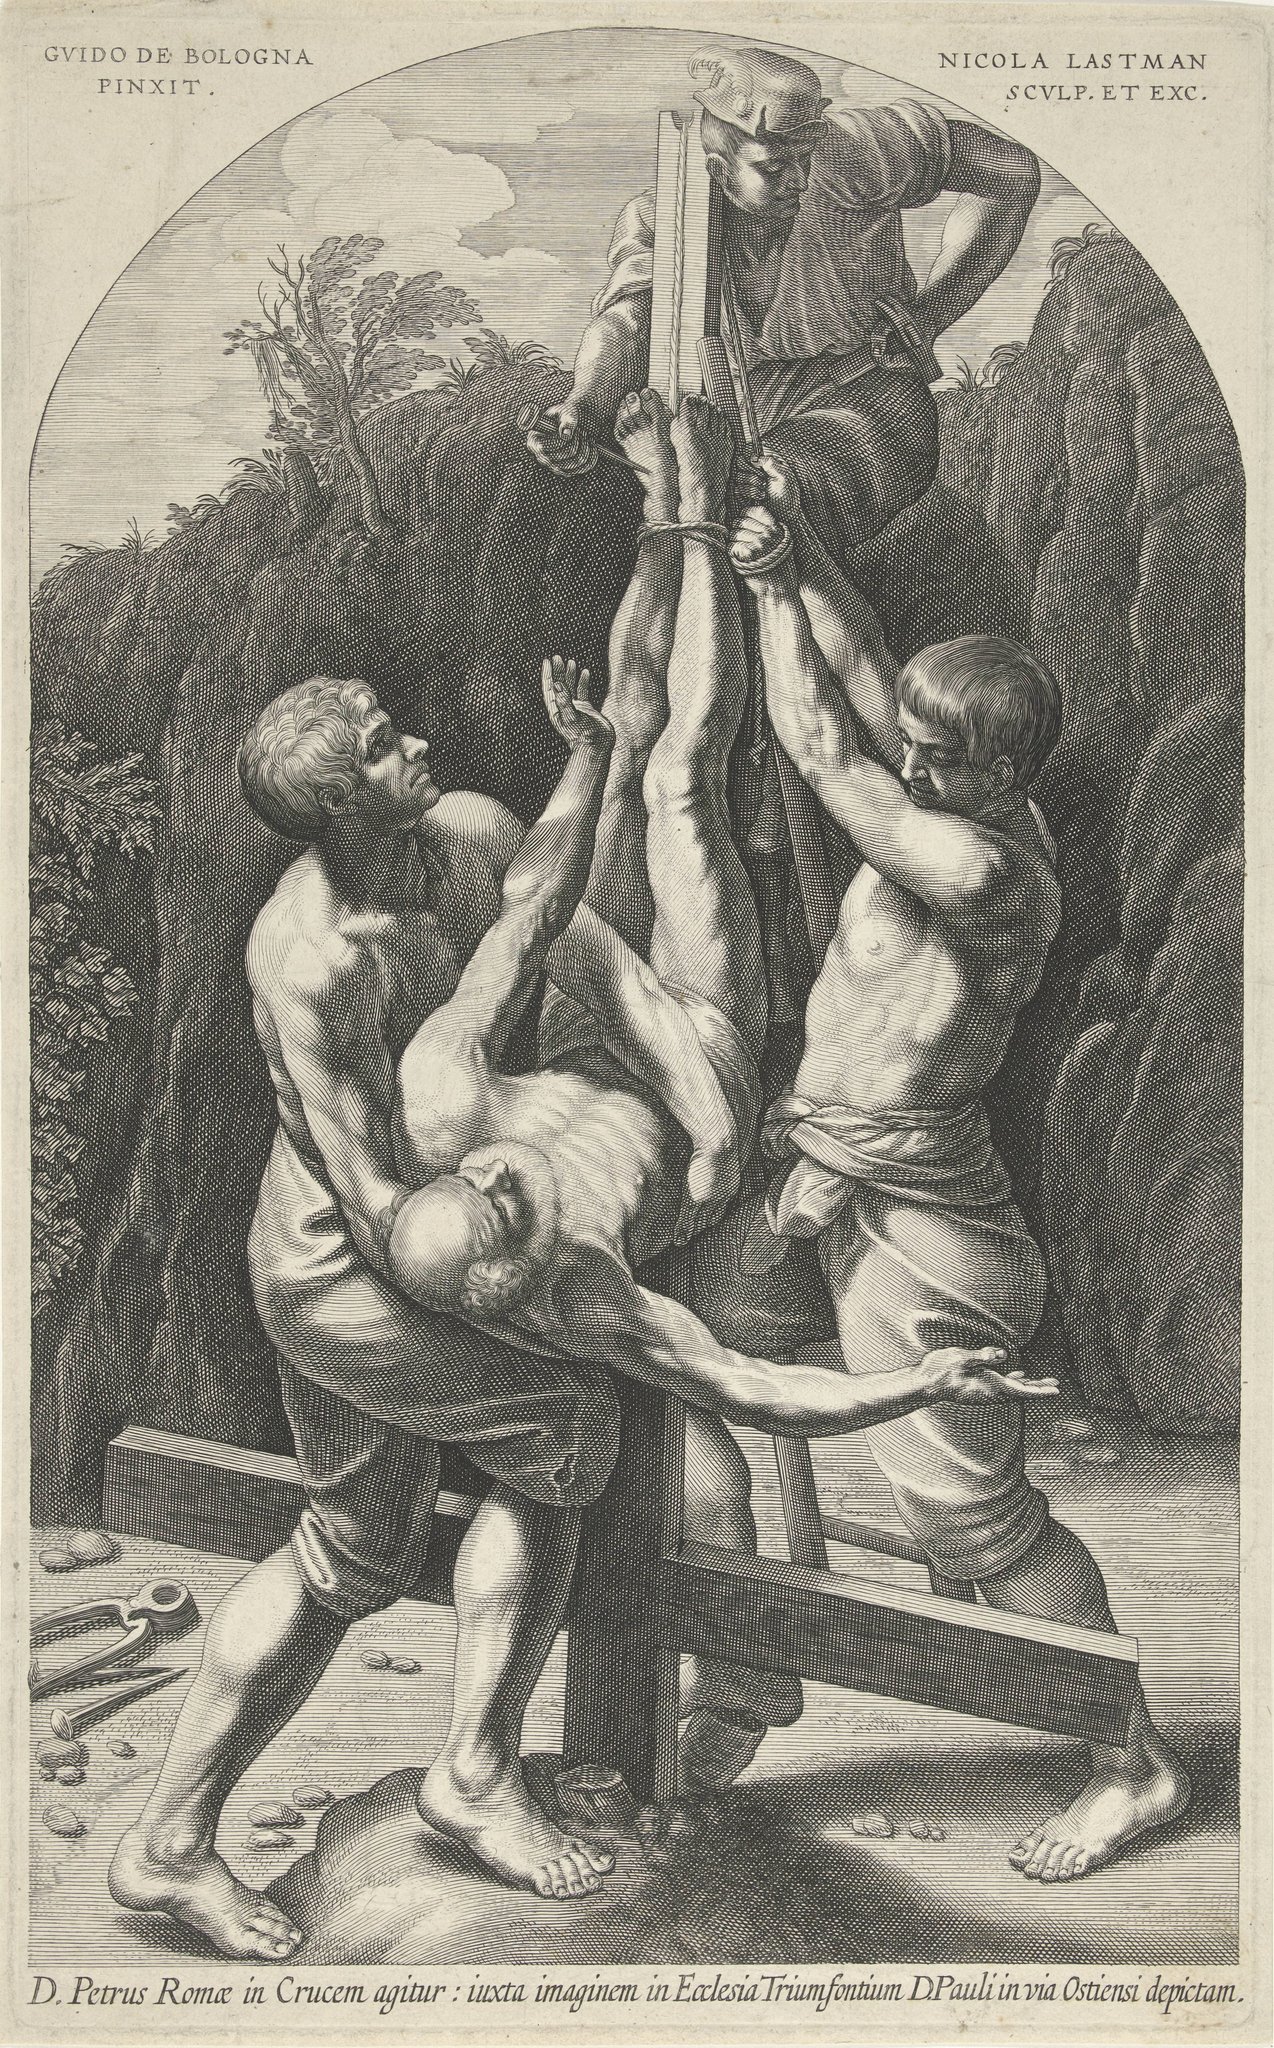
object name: print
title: Martelaarschap van Petrus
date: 1596-1625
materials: paper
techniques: engraving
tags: peter crucified upside down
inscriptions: collector's mark: Lugt 240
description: Petrus wordt door drie figuren op eigen verzoek met het hoofd naar beneden gekruisigd. In de marge een regel tekst in Latijn.